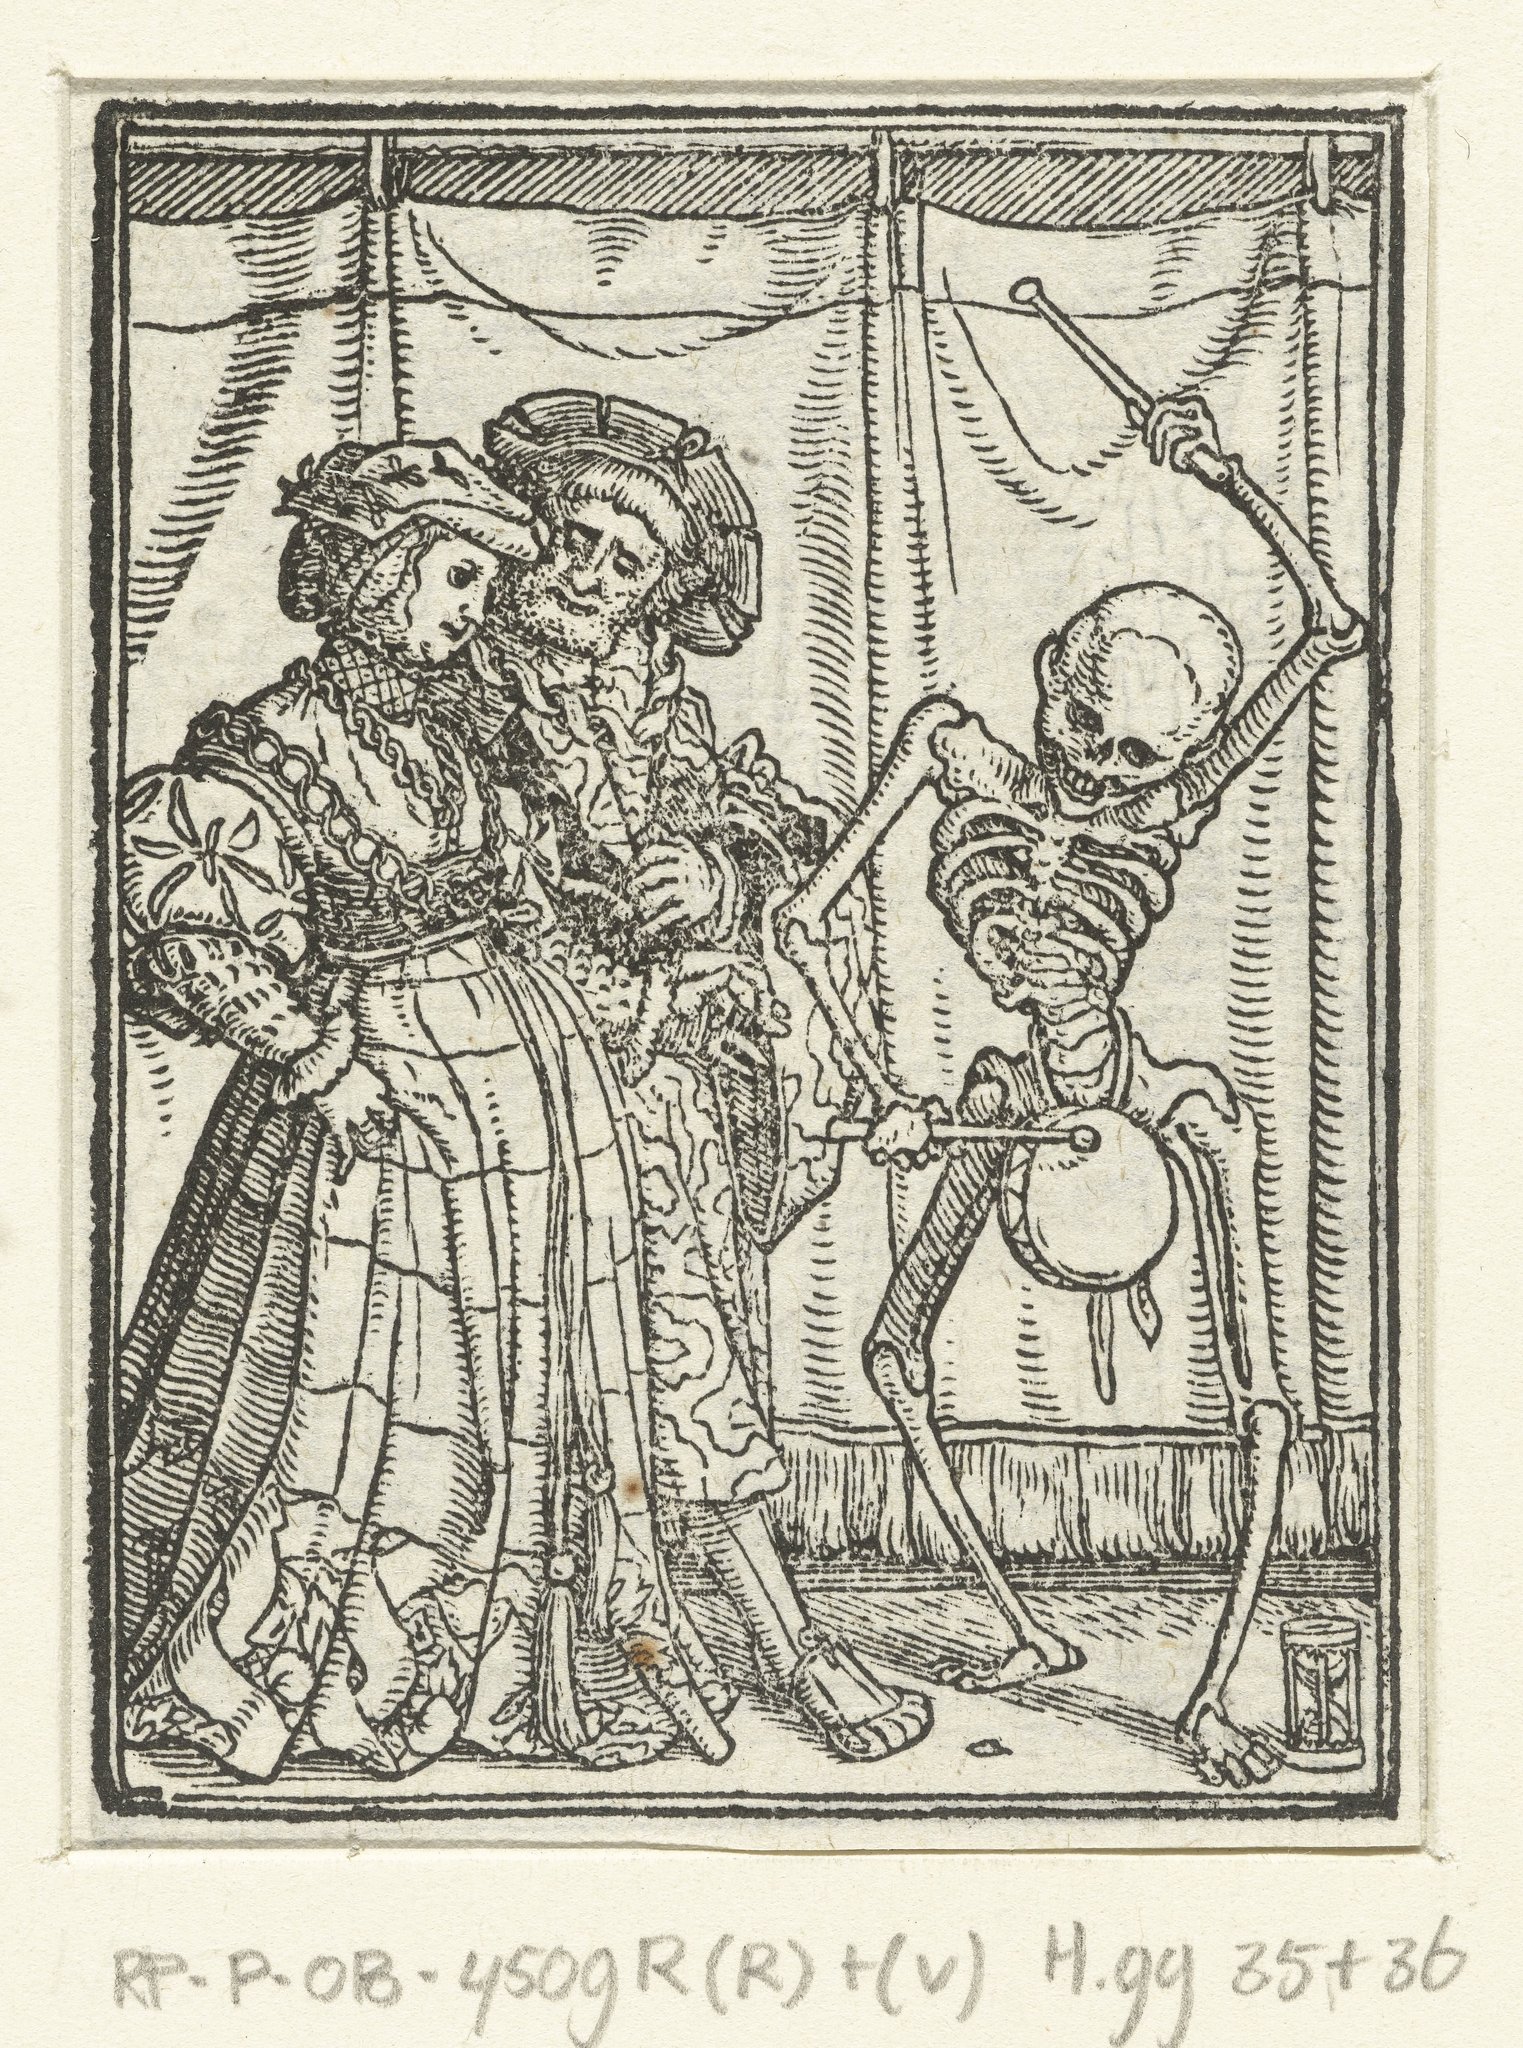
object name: print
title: Dodendans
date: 1524-1526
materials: paper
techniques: woodcut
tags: other sovereign (with title) - bb - female ruler, female sex; woman, dance of death; death together with one or more human beings, nobility and patriciate; chivalry, knighthood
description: De houtblokken werden voor 1526 vervaardigd door Hans Lützelburg en pas in 1538 voor het eerst gebruikt als boekillustraties in: Les simulachres & historiees faces de la mort avtant elegamment pourtraictes que artificiellement imaginées... a Lyon, Soubsz l'escu de Coloigne, MDXXXVIII, (M. en G. Trechsel, voor F. Frellon in Lyon), 1538. Later verschenen nog andere uitgaven.